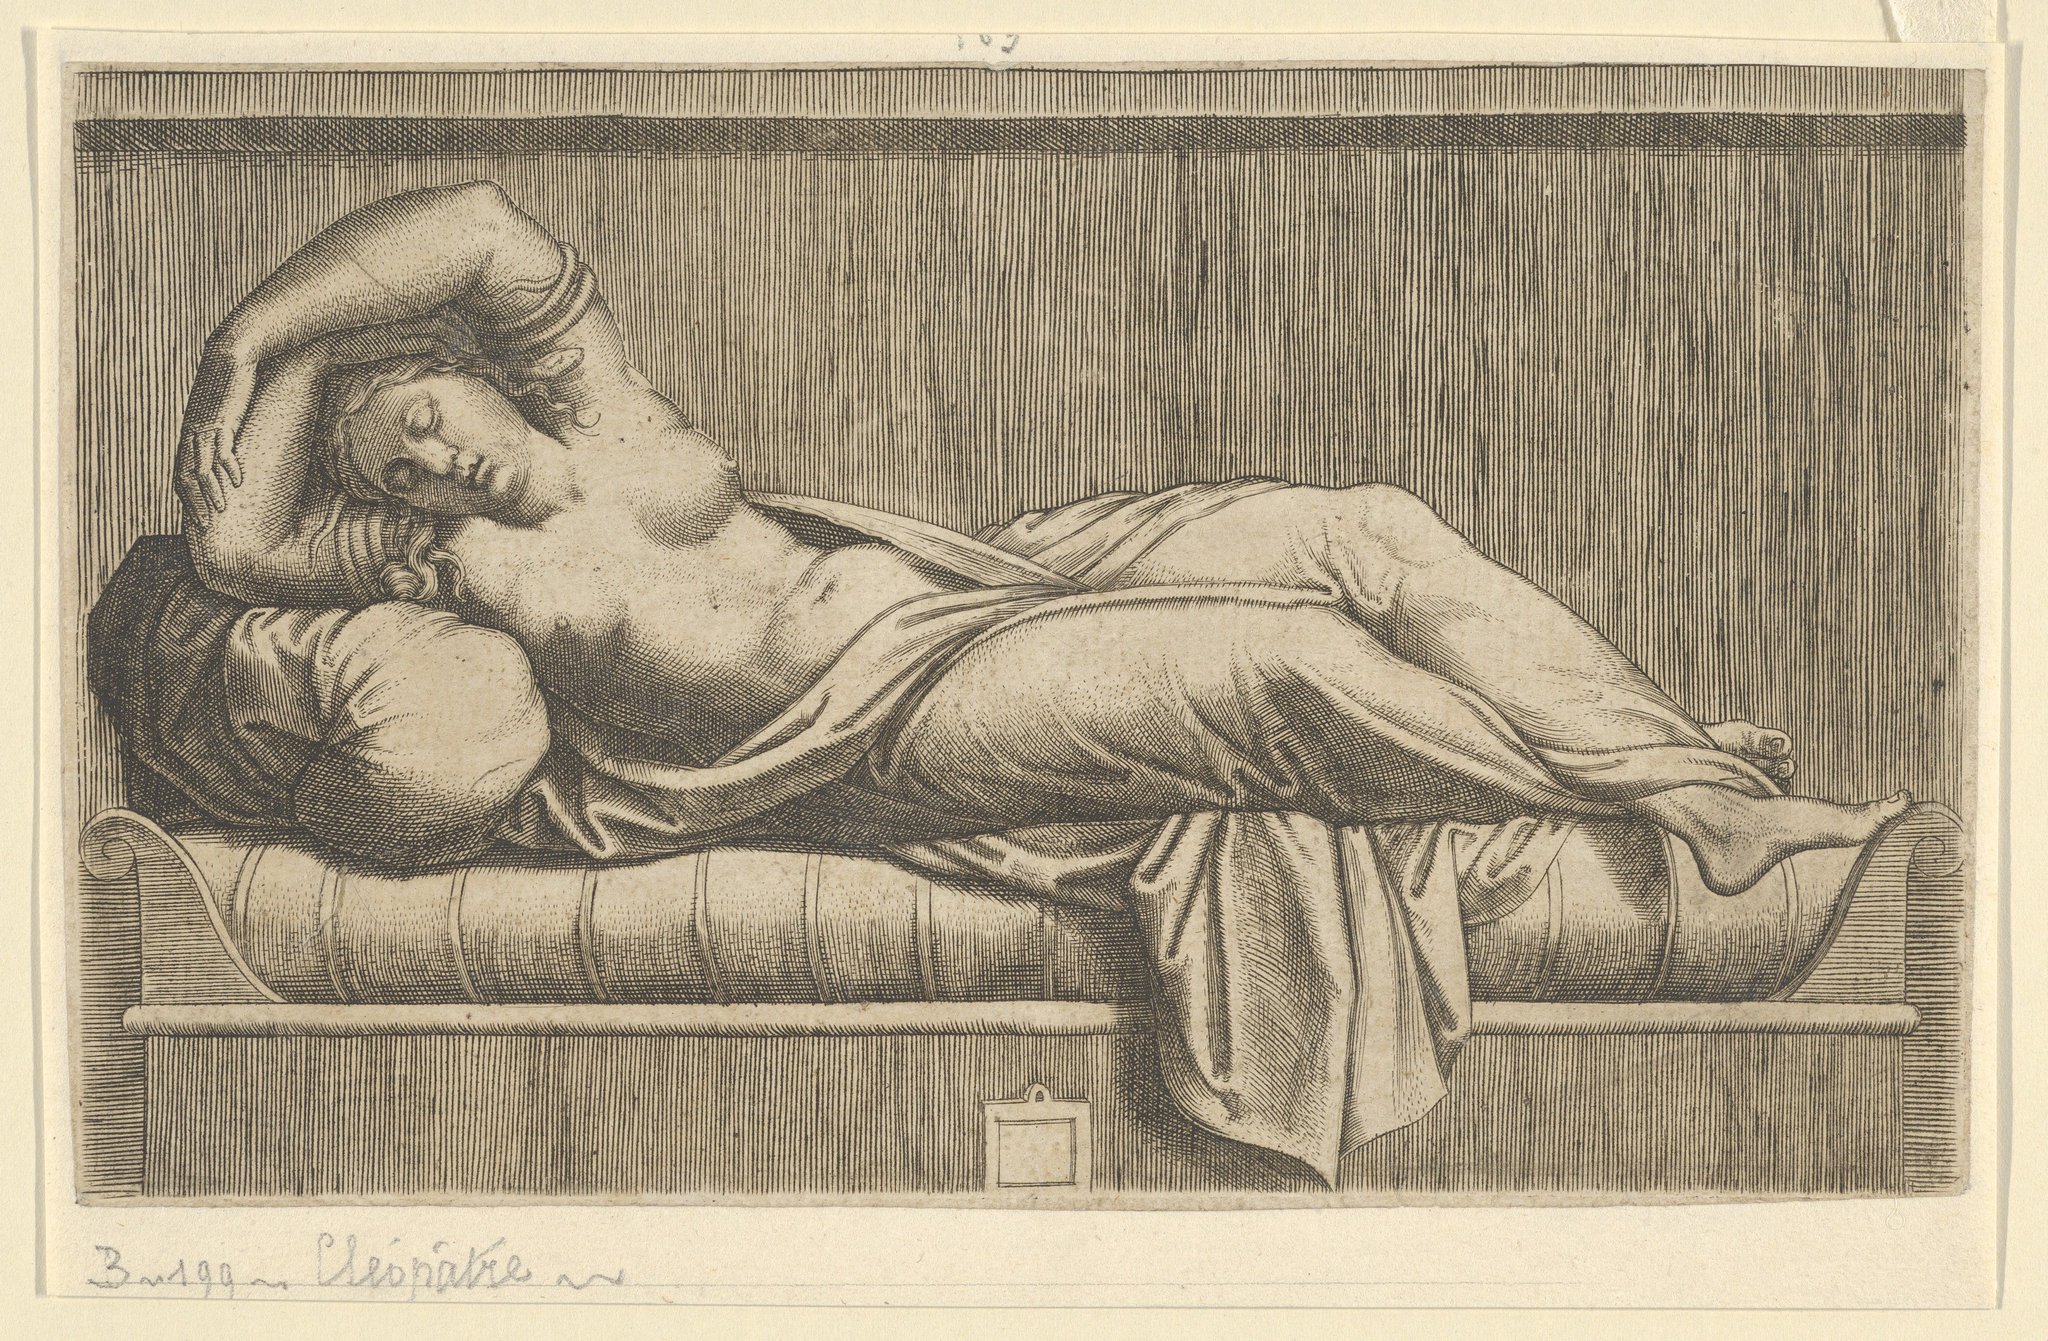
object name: print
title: Cleopatra, partly naked laying on a bed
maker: Anonymous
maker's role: artist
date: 1515-1540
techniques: engraving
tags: cleopatra,female nudes,beds